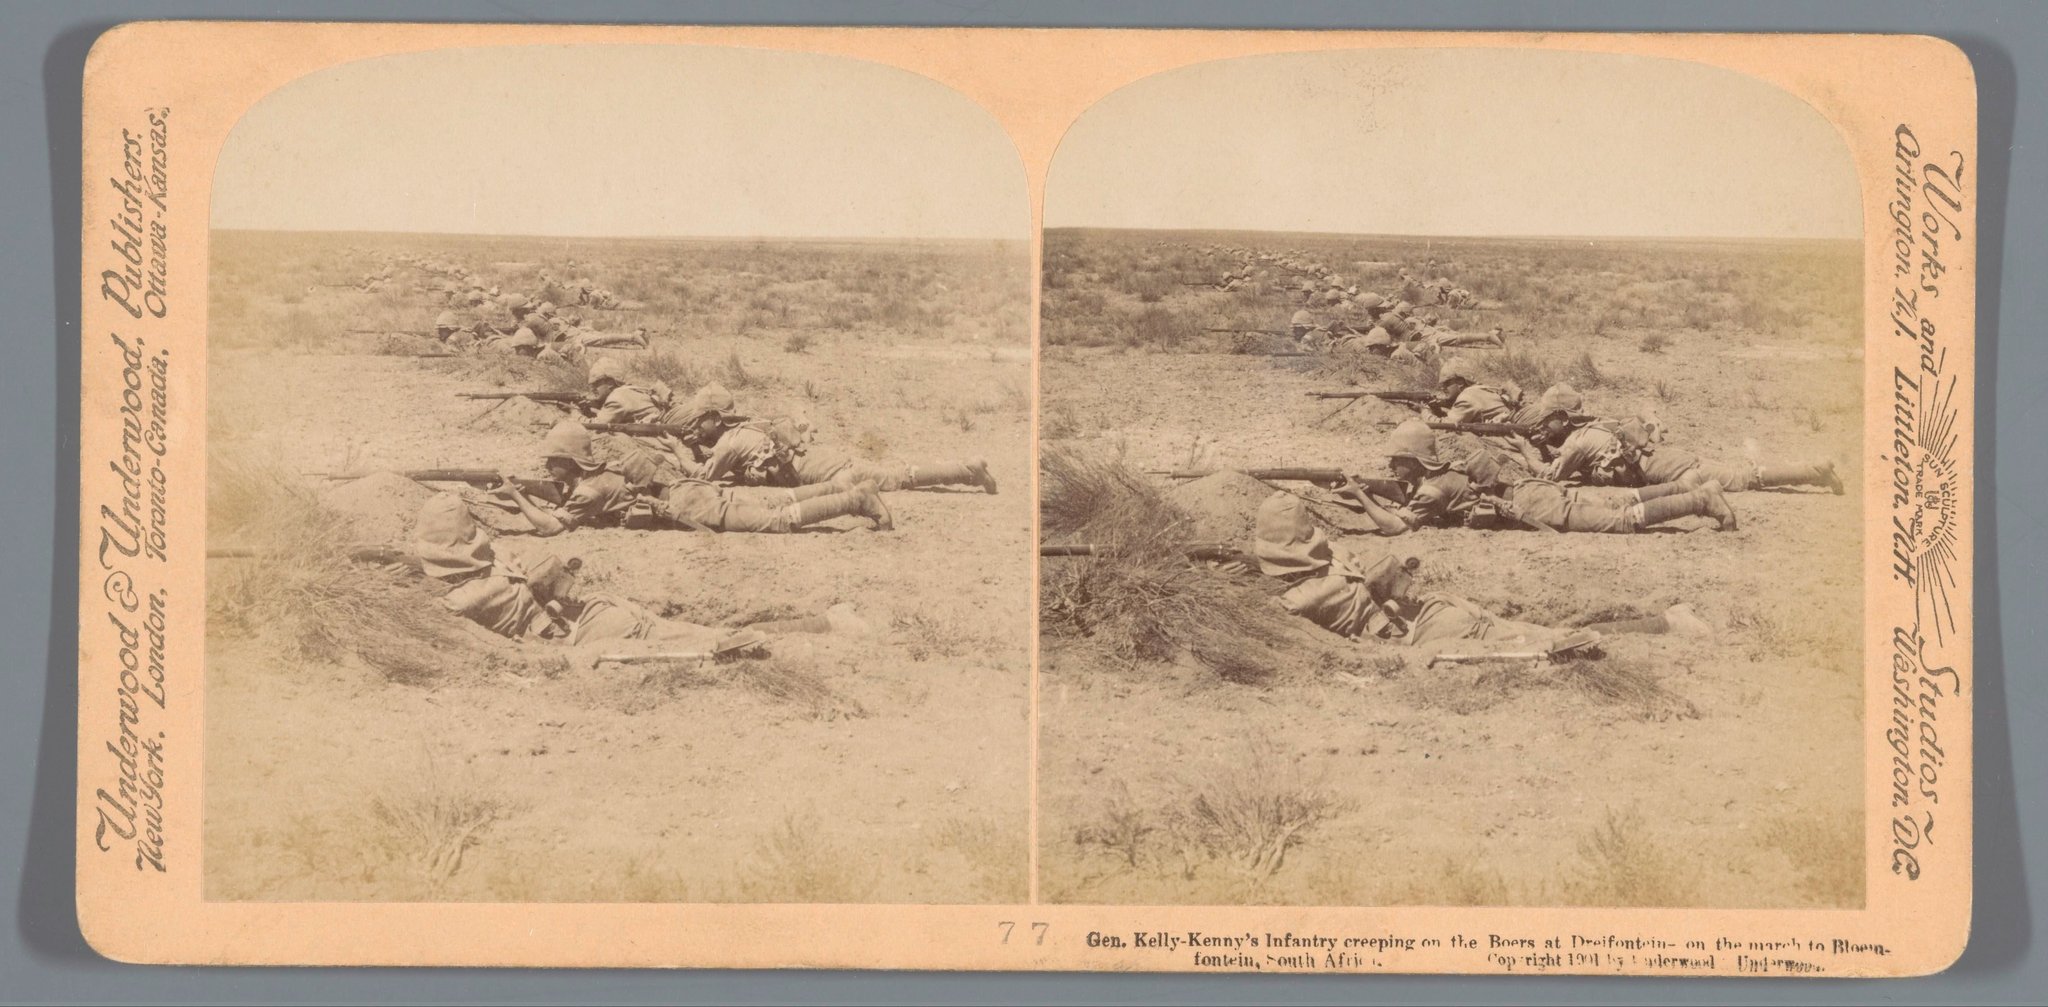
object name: stereograph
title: Gen. Kelly-Kenny's Infantry creeping on the Boers at Dreifontein - on the march to Bloemfontein, S.A.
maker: Anonymous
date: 1901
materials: cardboard, paper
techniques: albumen print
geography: driefontein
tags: fight between farmers and soldiers, siege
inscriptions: copyright notice: ‘Copyright 1901 by Underwood and Underwood.’, inscription: ‘Works and Studios ~/ Arlington, N.J. Littleton, N.H. Washington, D.C.’, number: ‘77’, inscription